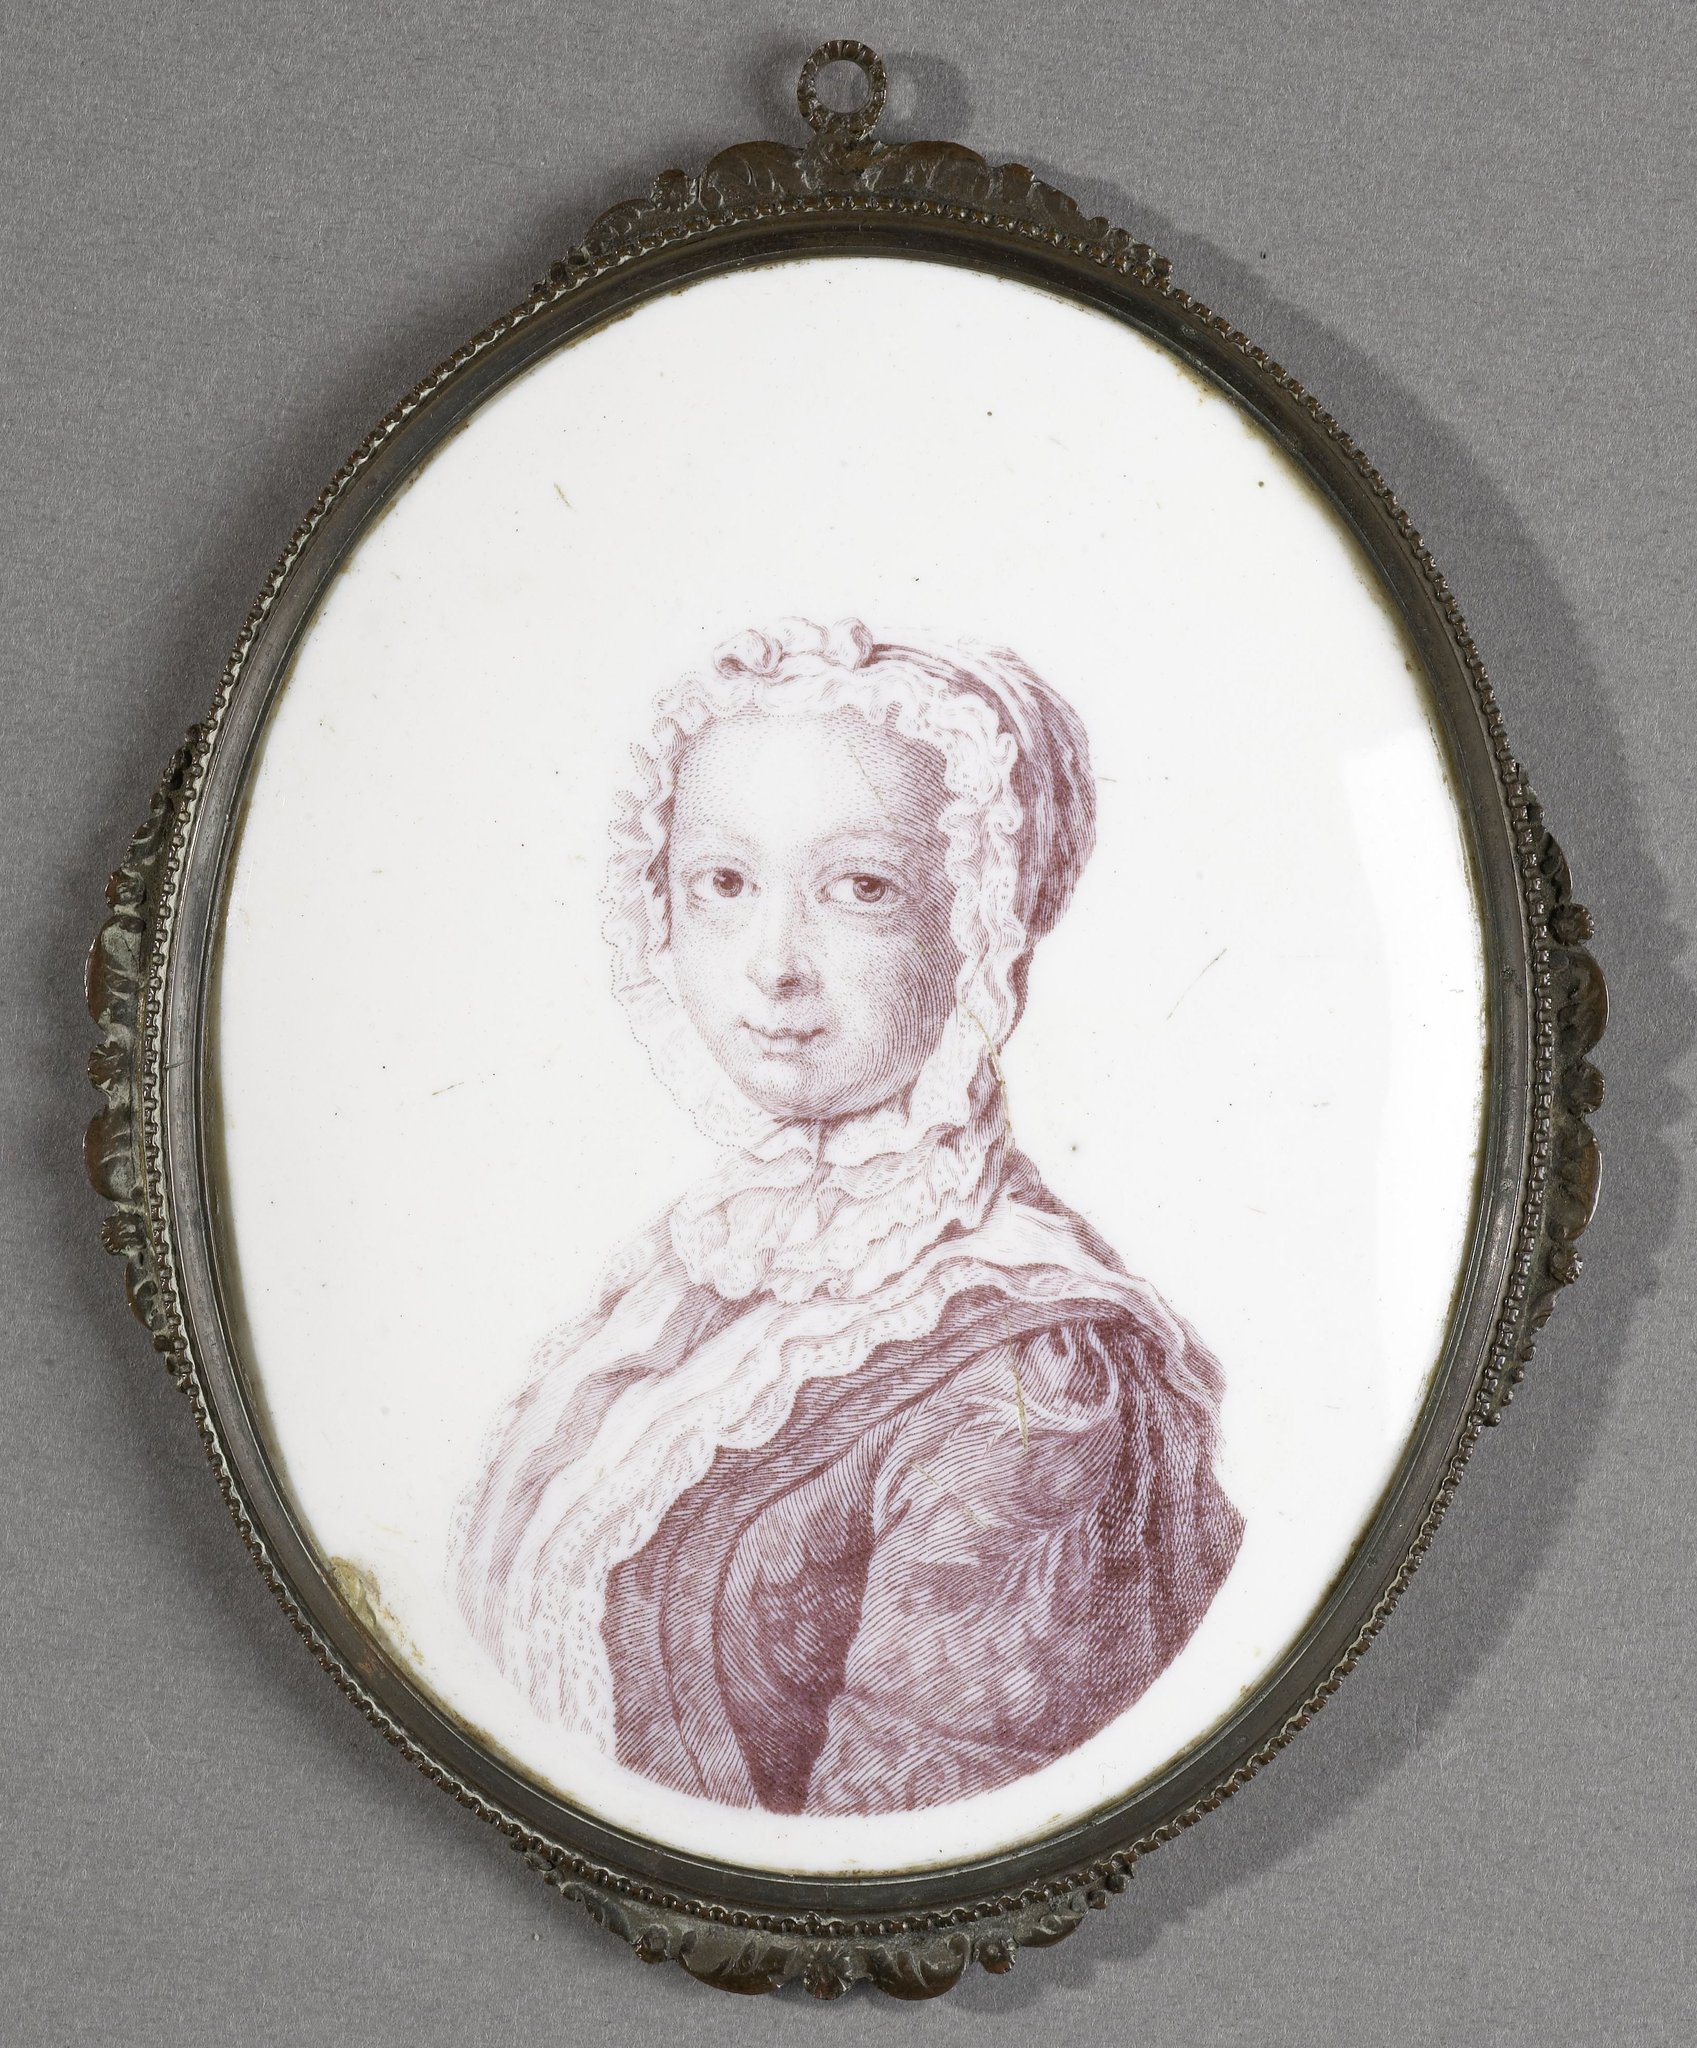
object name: painting, miniature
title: Anna van Hannover (1709-59). Zuster van Frederick Louis, Prins van Wales, en echtgenote van Prins Willem IV.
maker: Anonymous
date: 1735-1745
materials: copper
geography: england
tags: the hague, anna van hannover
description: Portret van Anna van Hannover (1709-59), zuster van Frederick Louis, de Prins van Wales, en echtgenote van Prins Willem IV. Buste naar links, aanziend. Naar een origineel uit 1736 door Bernardus Accama (I) in Rijksmuseum Paleis Het Loo, Apeldoorn. Vroeger geïnterpreteerd als een portret van Charles Edward Stuart (1720-88). Bonnie Prince Charlie in travestie in de japon van het dienstmeisje Betty Burke bij zijn vlucht van Benbecula (Hebriden) naar Skye in 1746. Onderdeel van de collectie portretminiaturen.